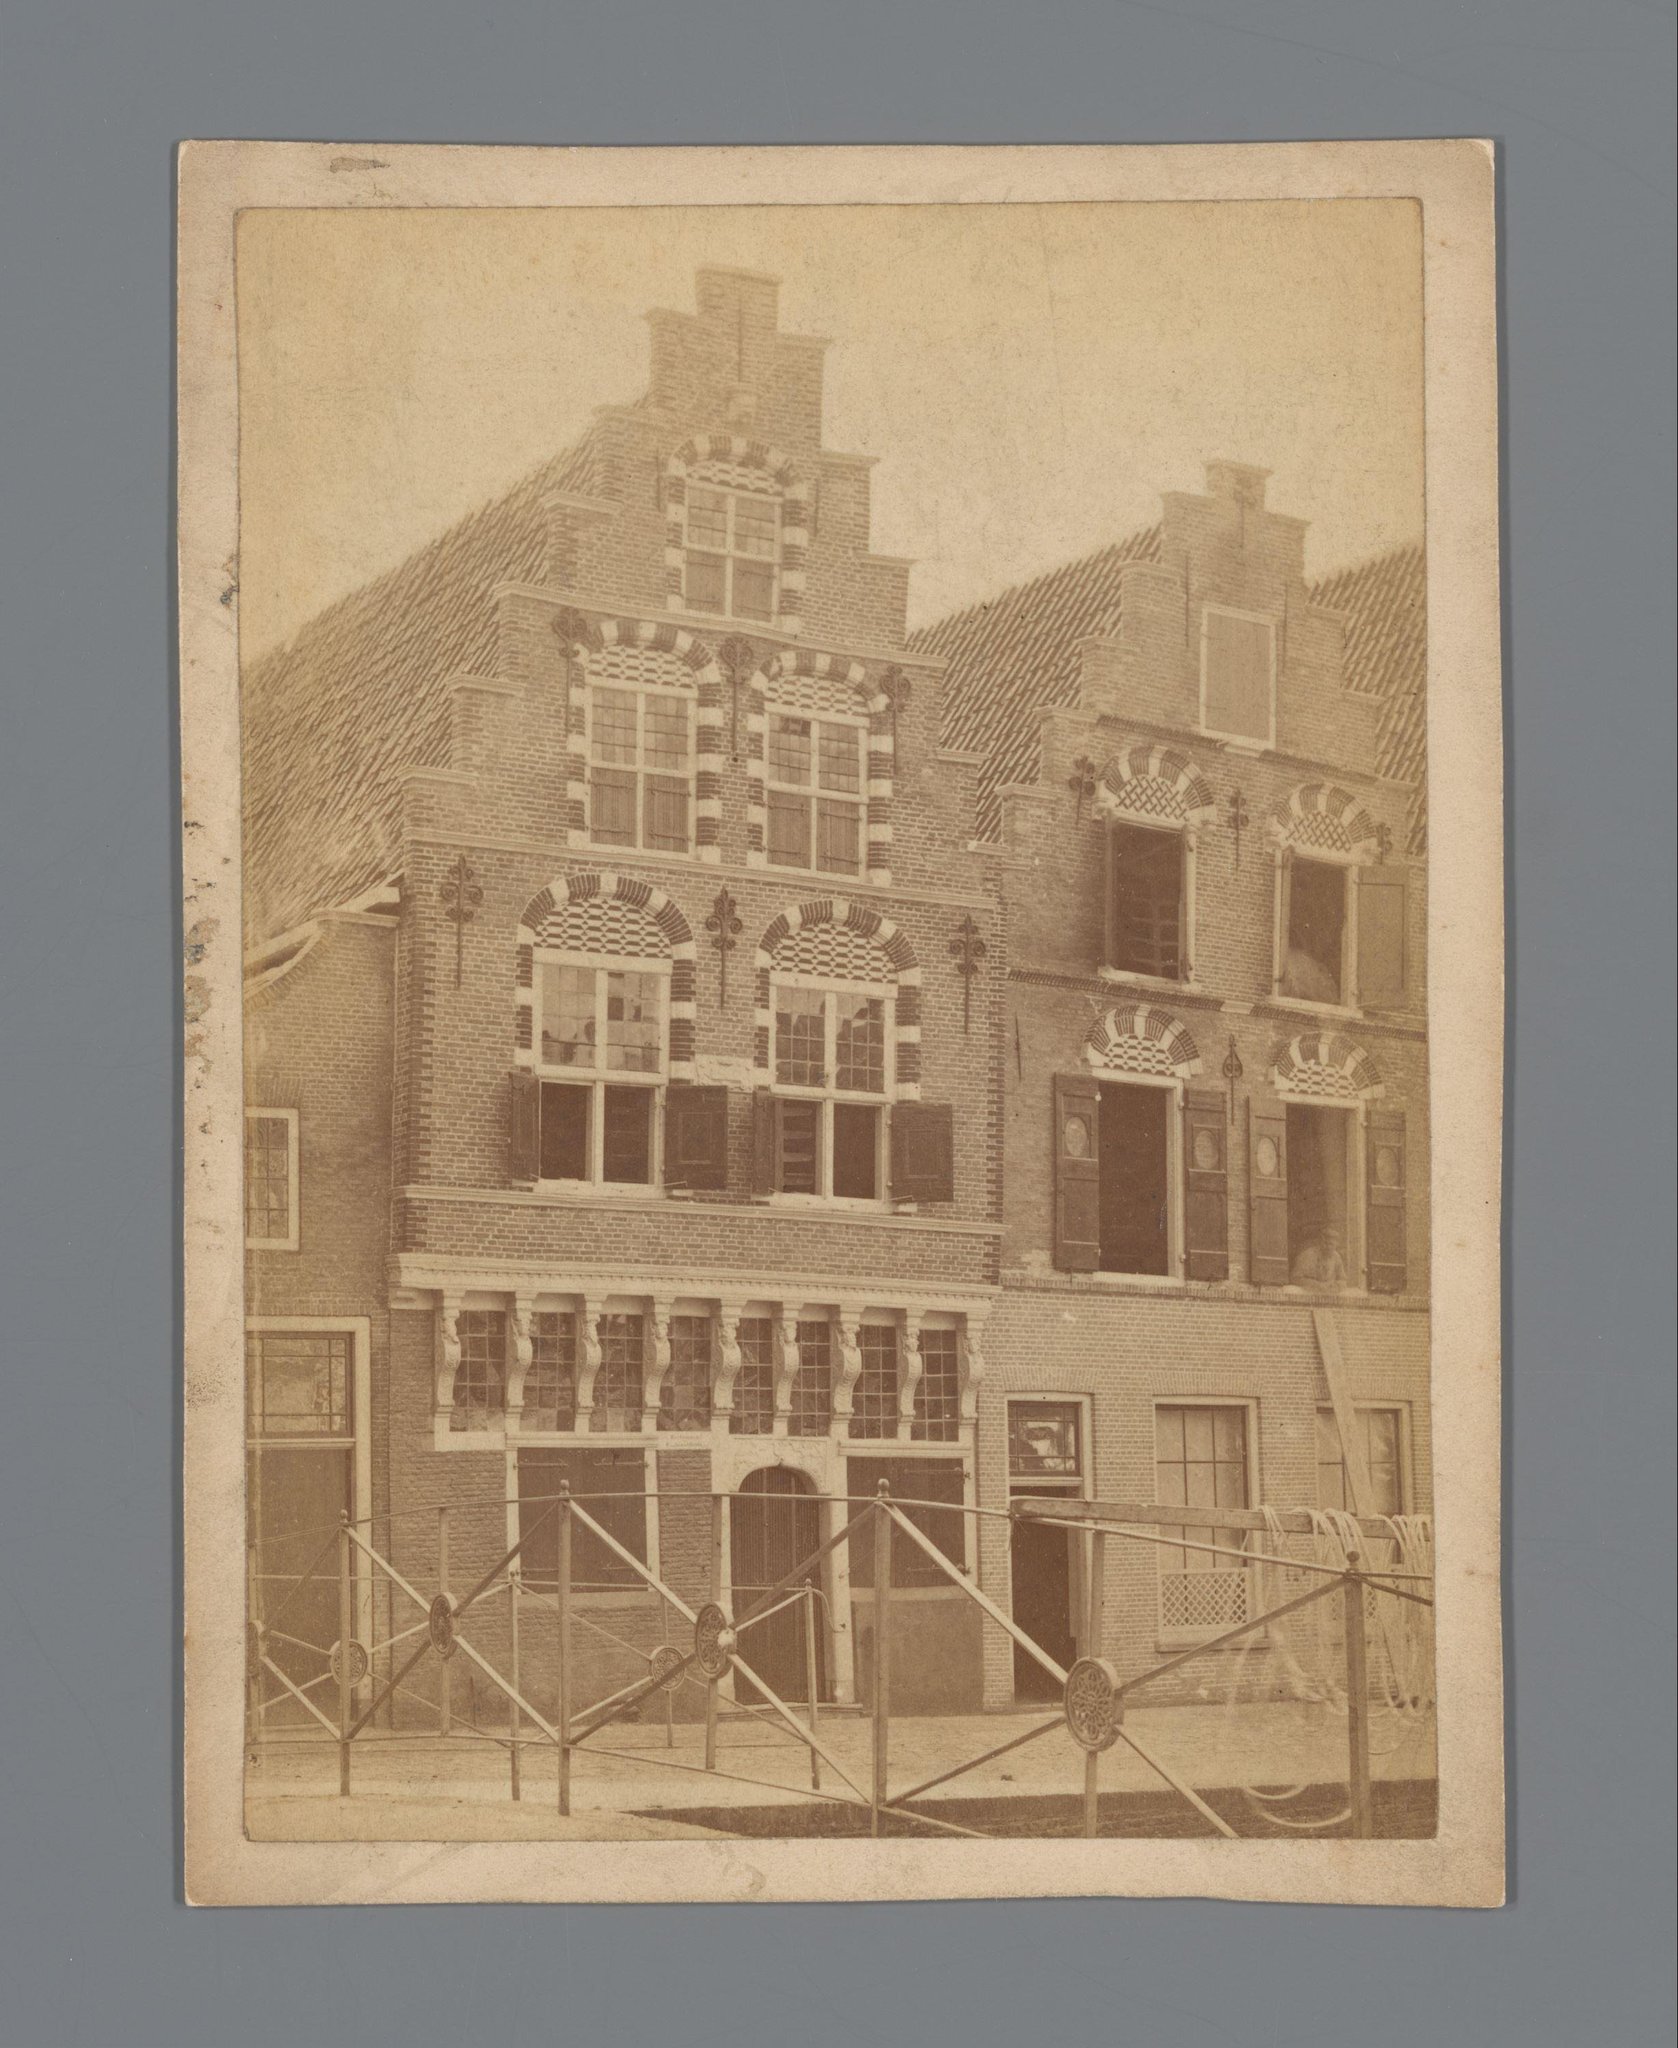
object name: photograph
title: Gezicht op twee gedecoreerde façades op de Donkere Gaard te Oudewater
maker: Anonymous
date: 1860-1900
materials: cardboard, photographic support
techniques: albumen print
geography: oudewater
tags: urban housing, façade (of house or building)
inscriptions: annotation: ‘Oudewater/ Z-H’